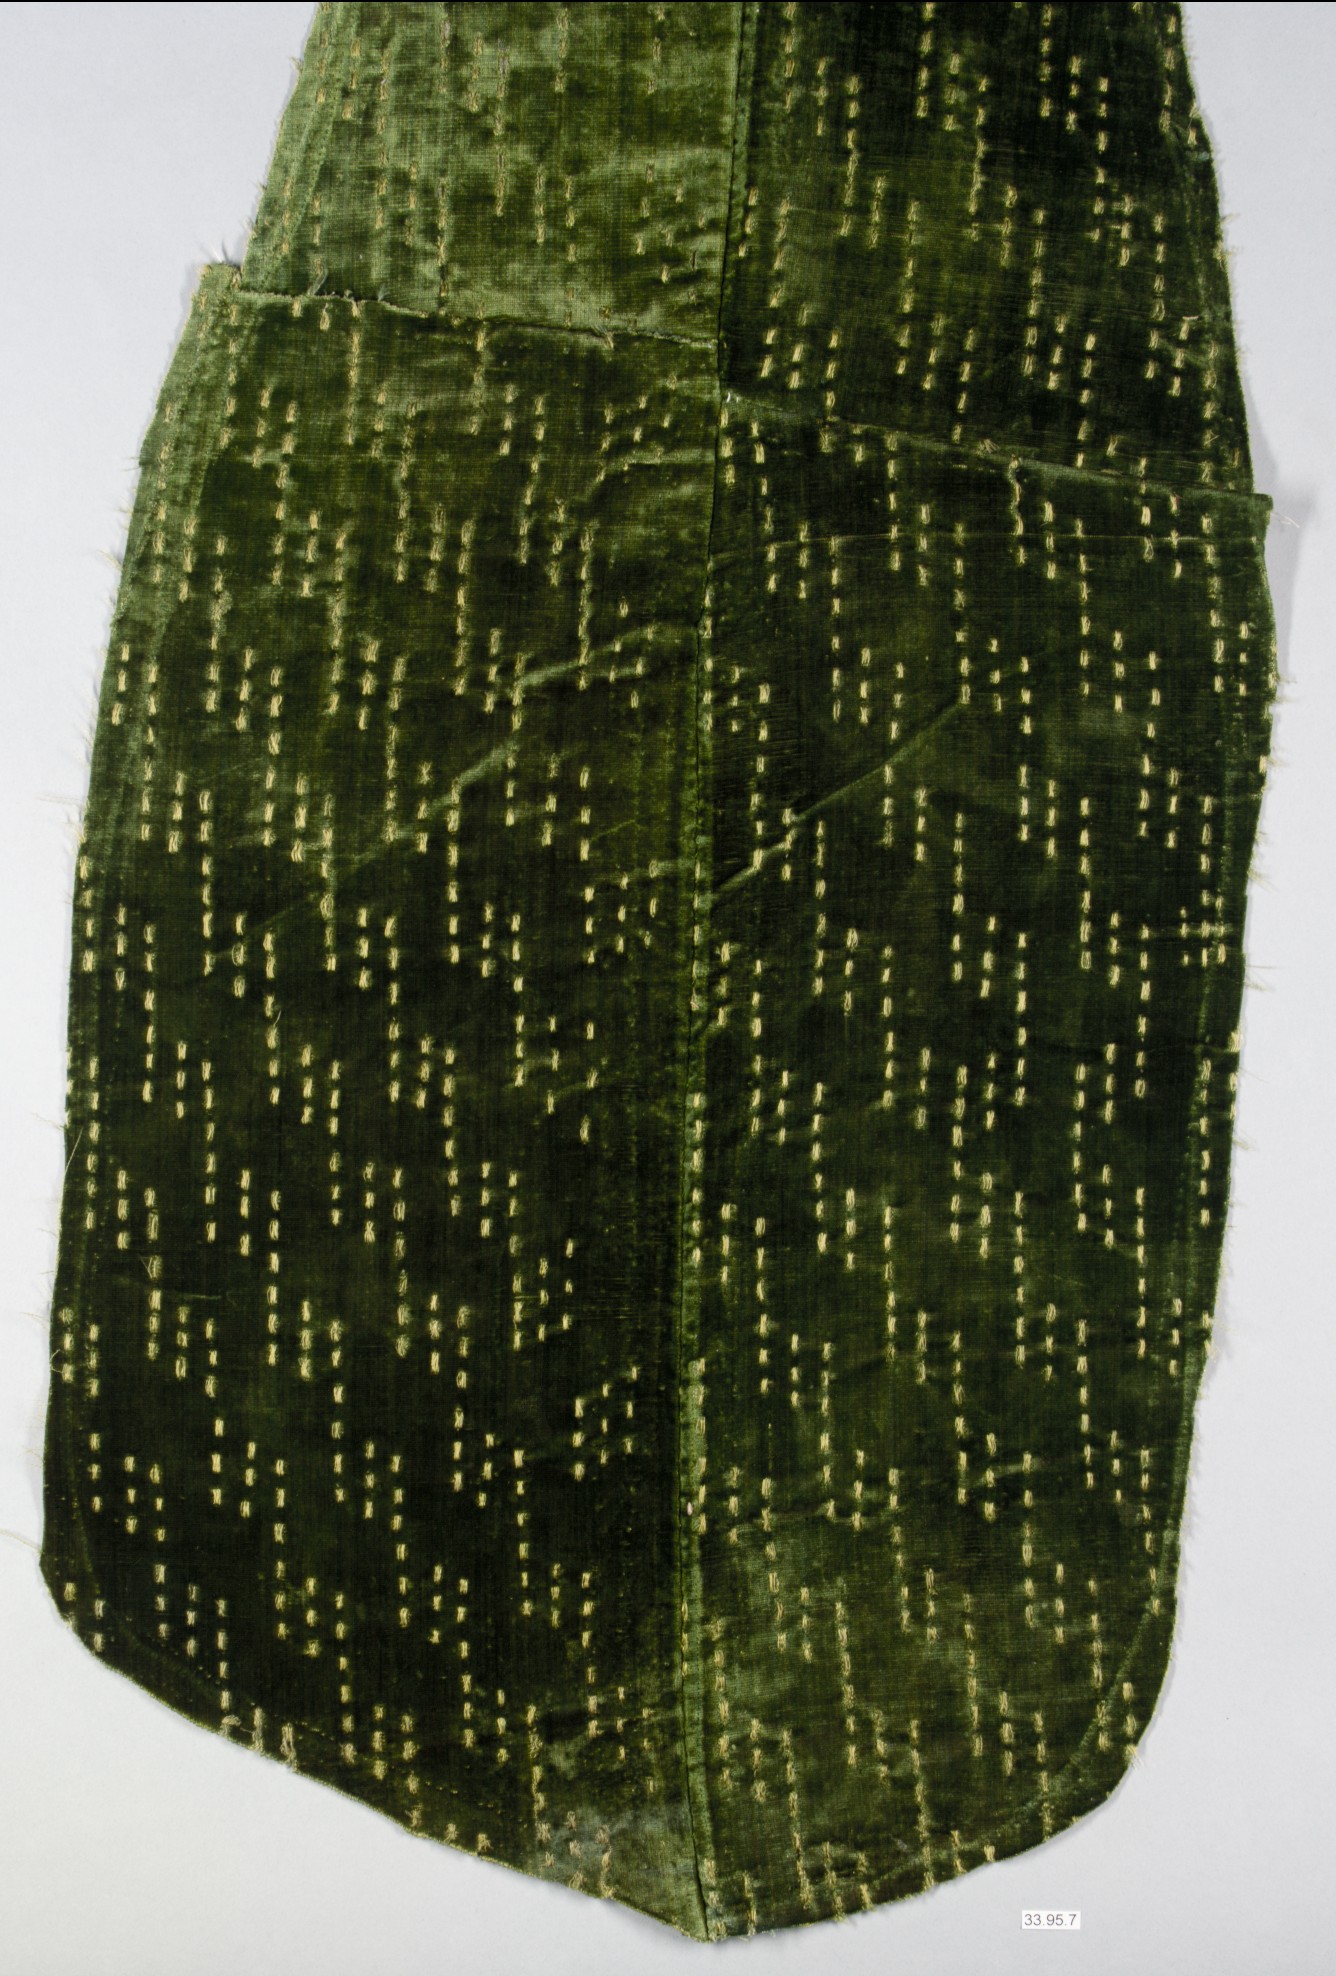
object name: fragment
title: Velvet fragments with slashed pattern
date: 1501-1700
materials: silk